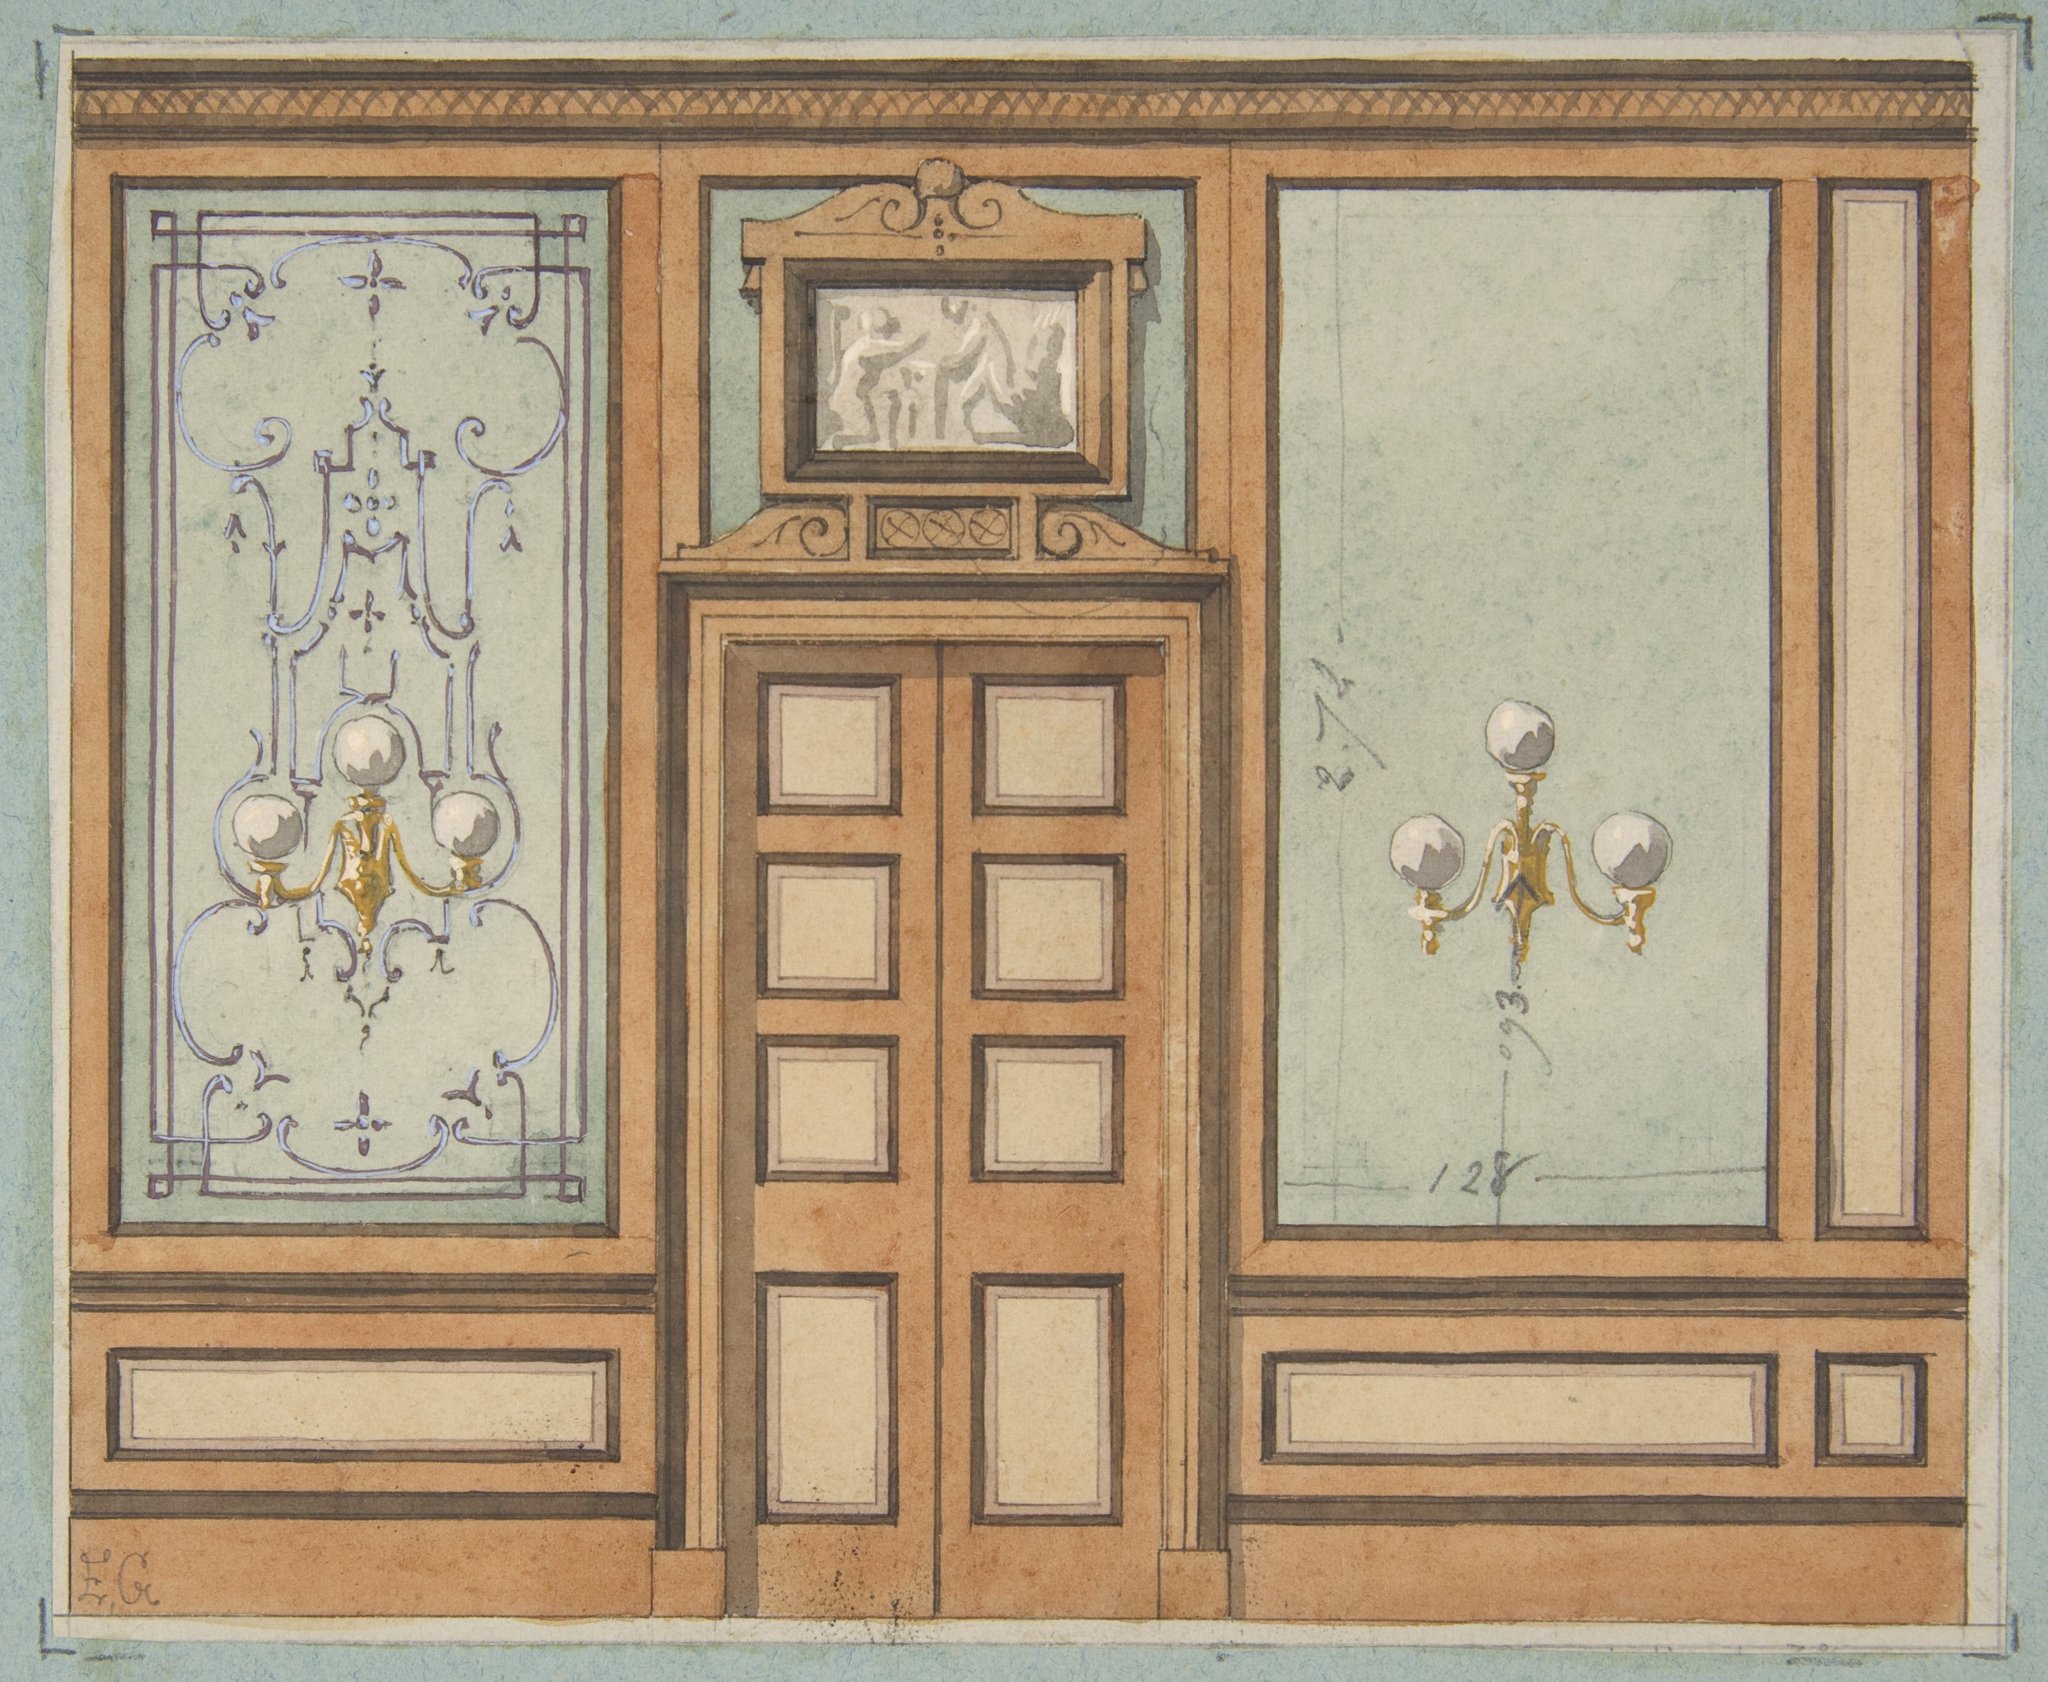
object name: drawing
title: Elevation of a paneled interior with double doors and gaslight sconces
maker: jules-edmond-charles lachaise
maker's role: artist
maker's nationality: french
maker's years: 1897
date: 1830-1897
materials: graphite, ink, watercolor, paper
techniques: pen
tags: architecture,doors